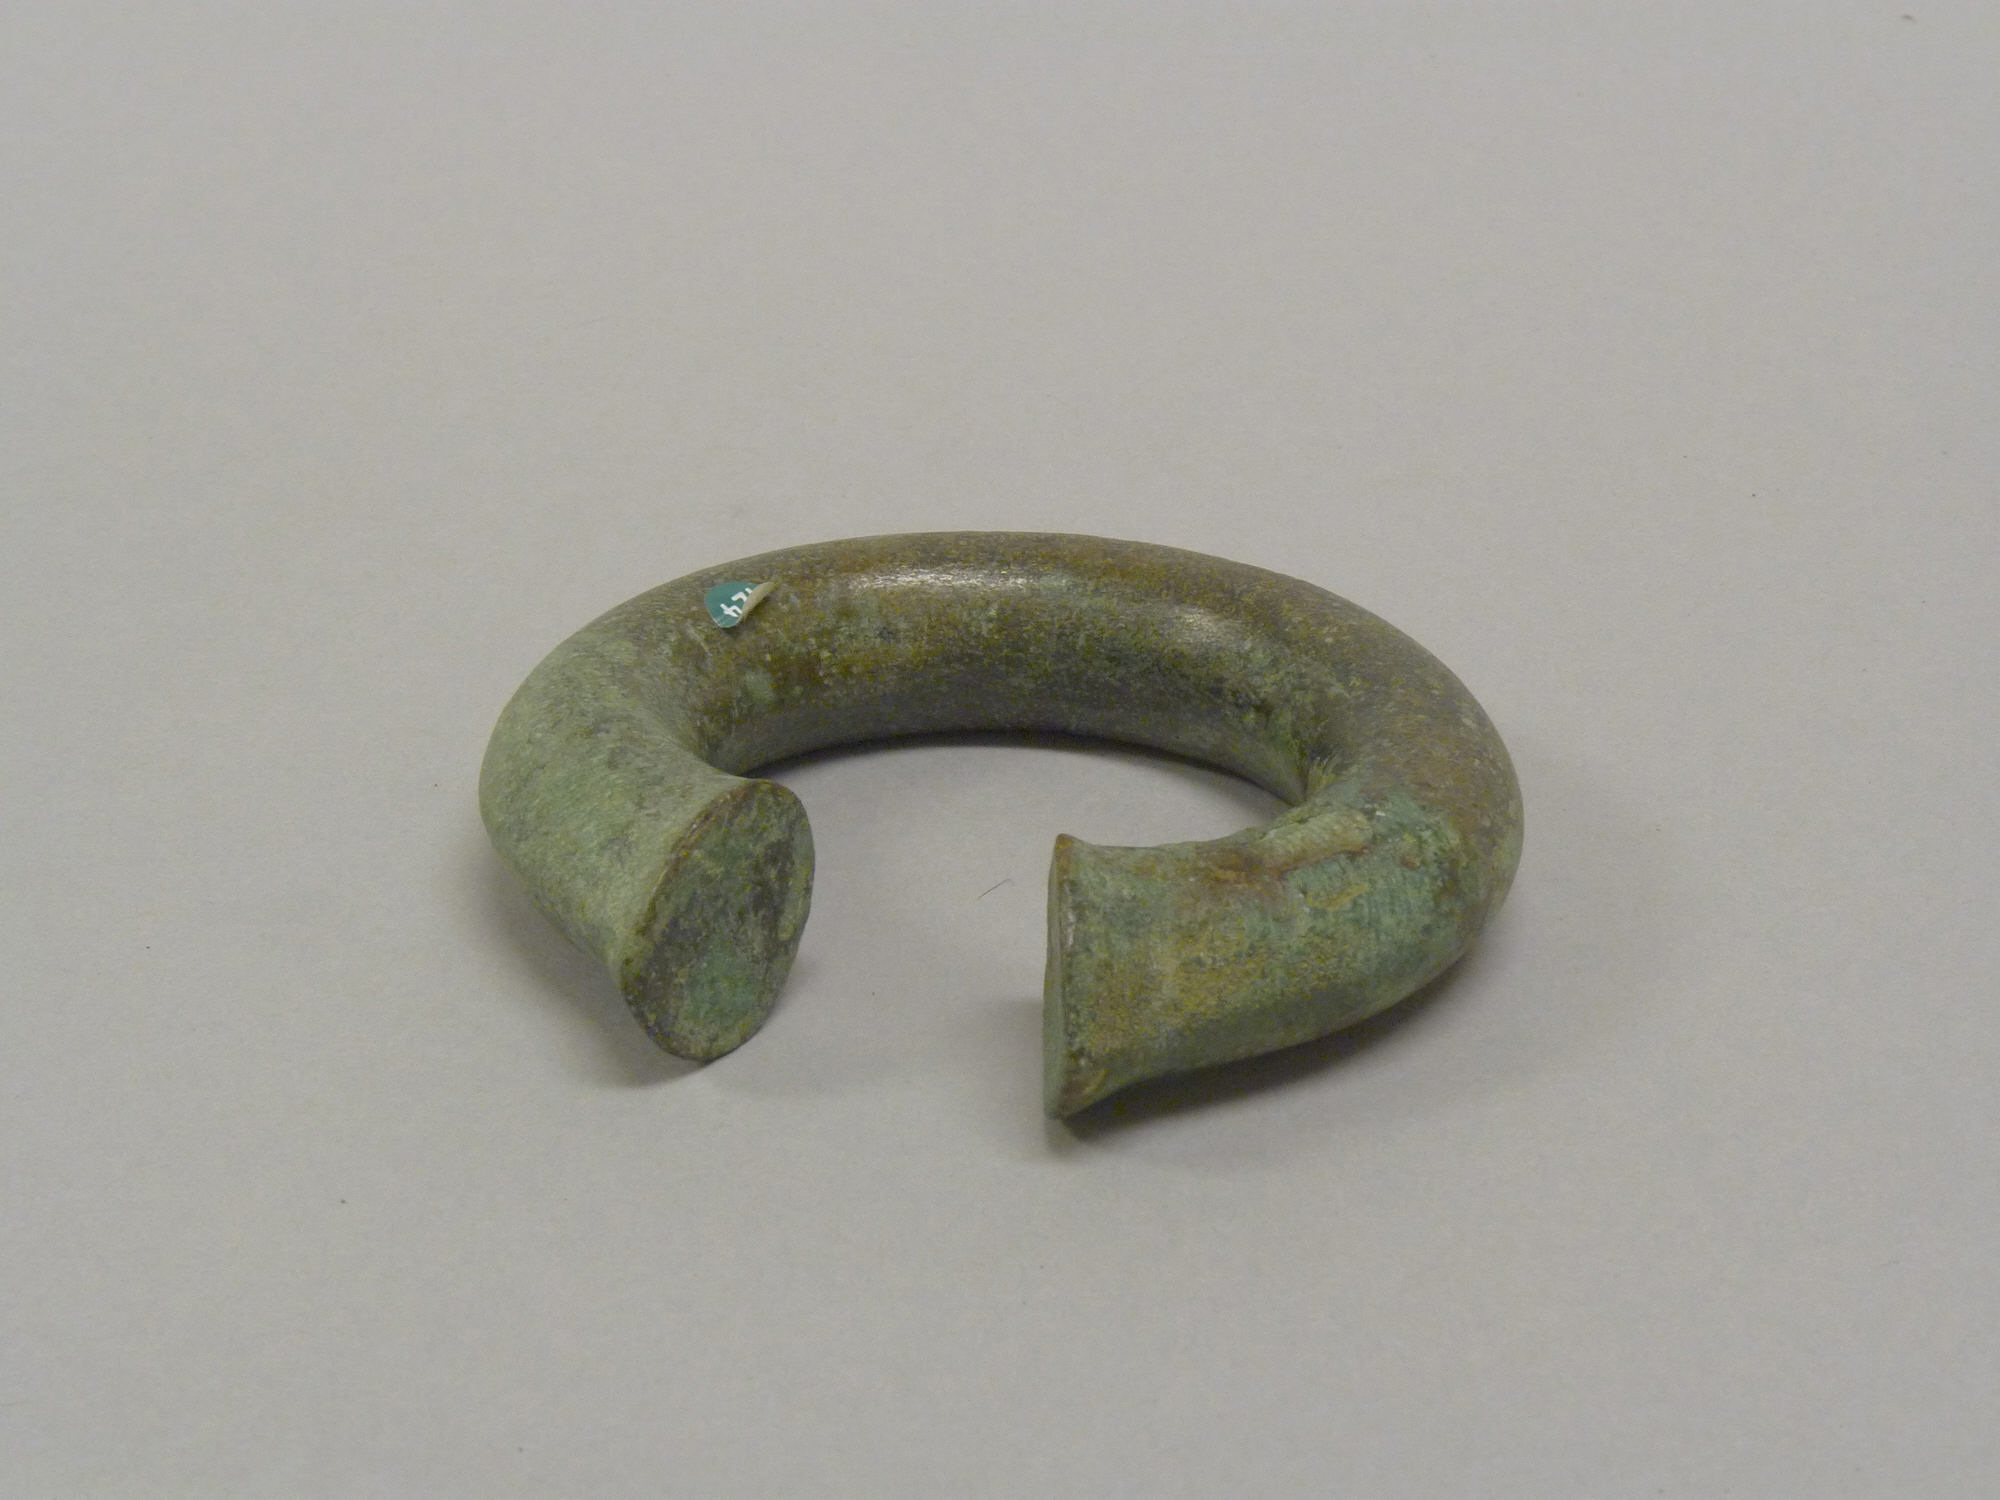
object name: one of a pair of bangle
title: One from a Pair of Solid Open Bangles with Shaved Ends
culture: thai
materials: bronze